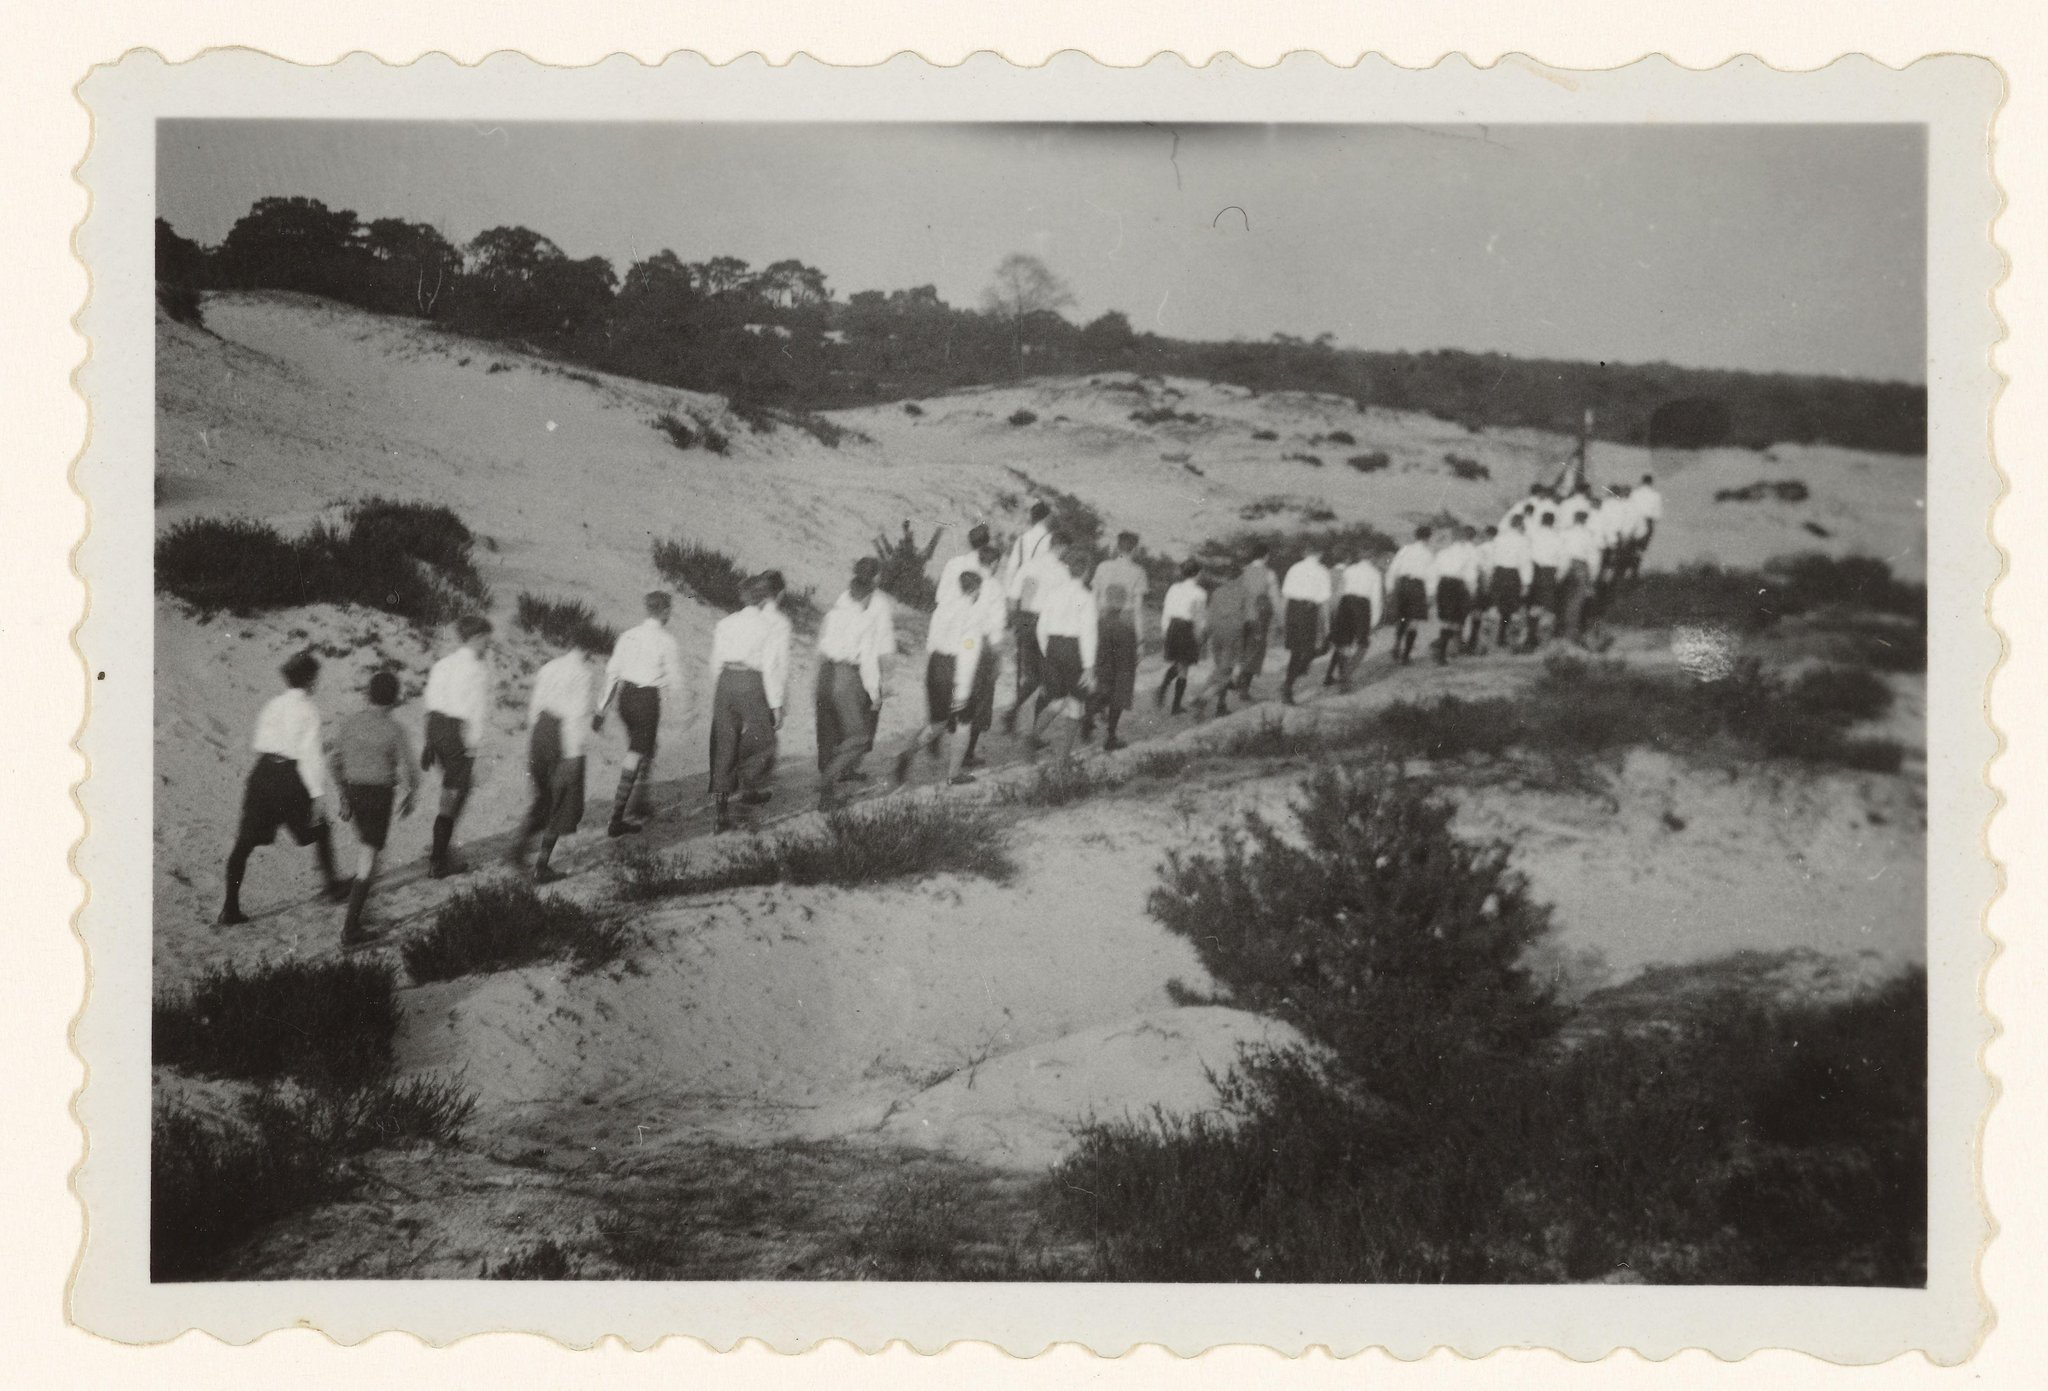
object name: photograph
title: Jeugdstorm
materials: photographic support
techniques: gelatin silver print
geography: bilthoven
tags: politieke partij, nsb, nationale jeugdstorm (njs), bilthoven, tweede wereldoorlog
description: Leden van de Jeugdstorm lopen door een zanderig gebied, de meesten in uniform, tijdens een jeugdkamp.